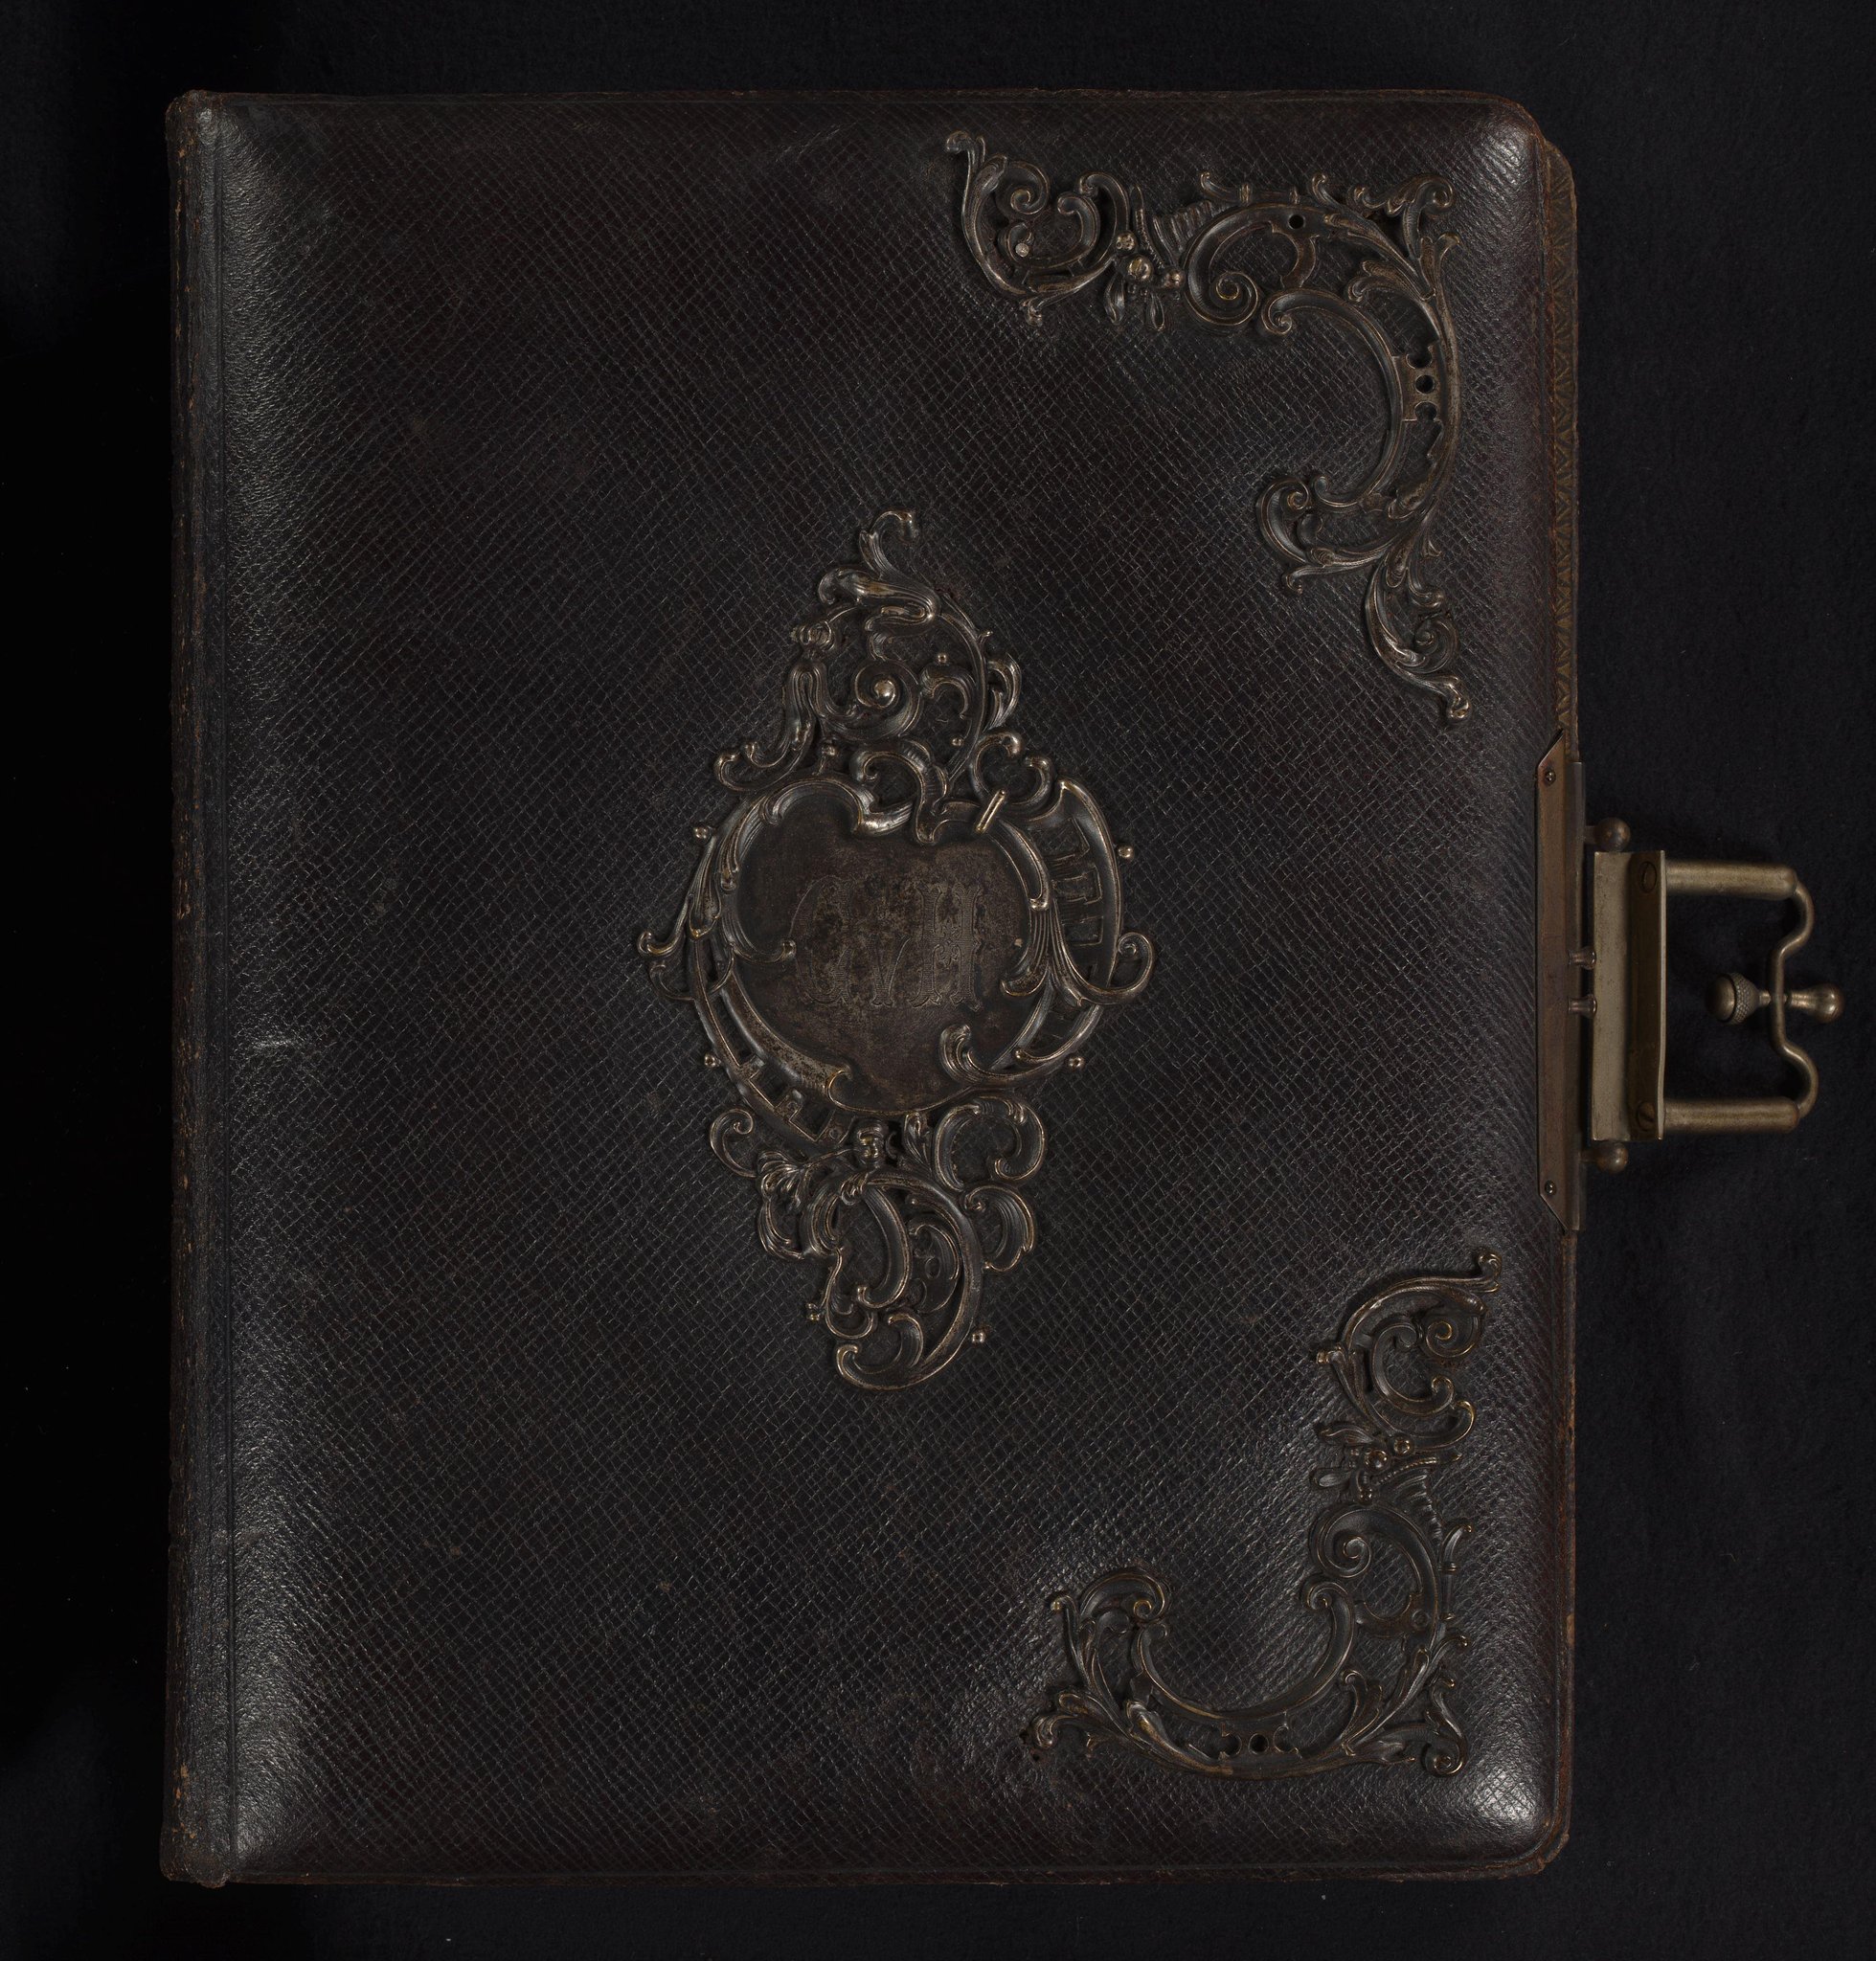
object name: slip in album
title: Fotoalbum met portretten van de familie Van Hoecke met 41 foto's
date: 1860-1920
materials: cardboard, leather, metal, paper, photographic support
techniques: albumen print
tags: historical persons - bb - woman, historical persons, head-gear: cap, dog, anonymous historical persons portrayed in a group, in a group-portrait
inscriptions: collector's mark: ‘Dienst Verspreide Rijkskollekties (...) A 687’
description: Fotoalbum met 41 foto’s op 12 bladen met insteekpasse-partouts op carte-de-visite-formaat en kabinetfoto's. Het album bevat voornamelijk portretten, onder andere Roger en Raymonde van Hoecke. Daarnaast bevat het album enkele groepsportretten en foto's van een hond. De foto's zijn vervaardigd in Frankrijk, België en Indonesië door onder andere Georges Verger, O. Kurkdjian en L. Tronchet.